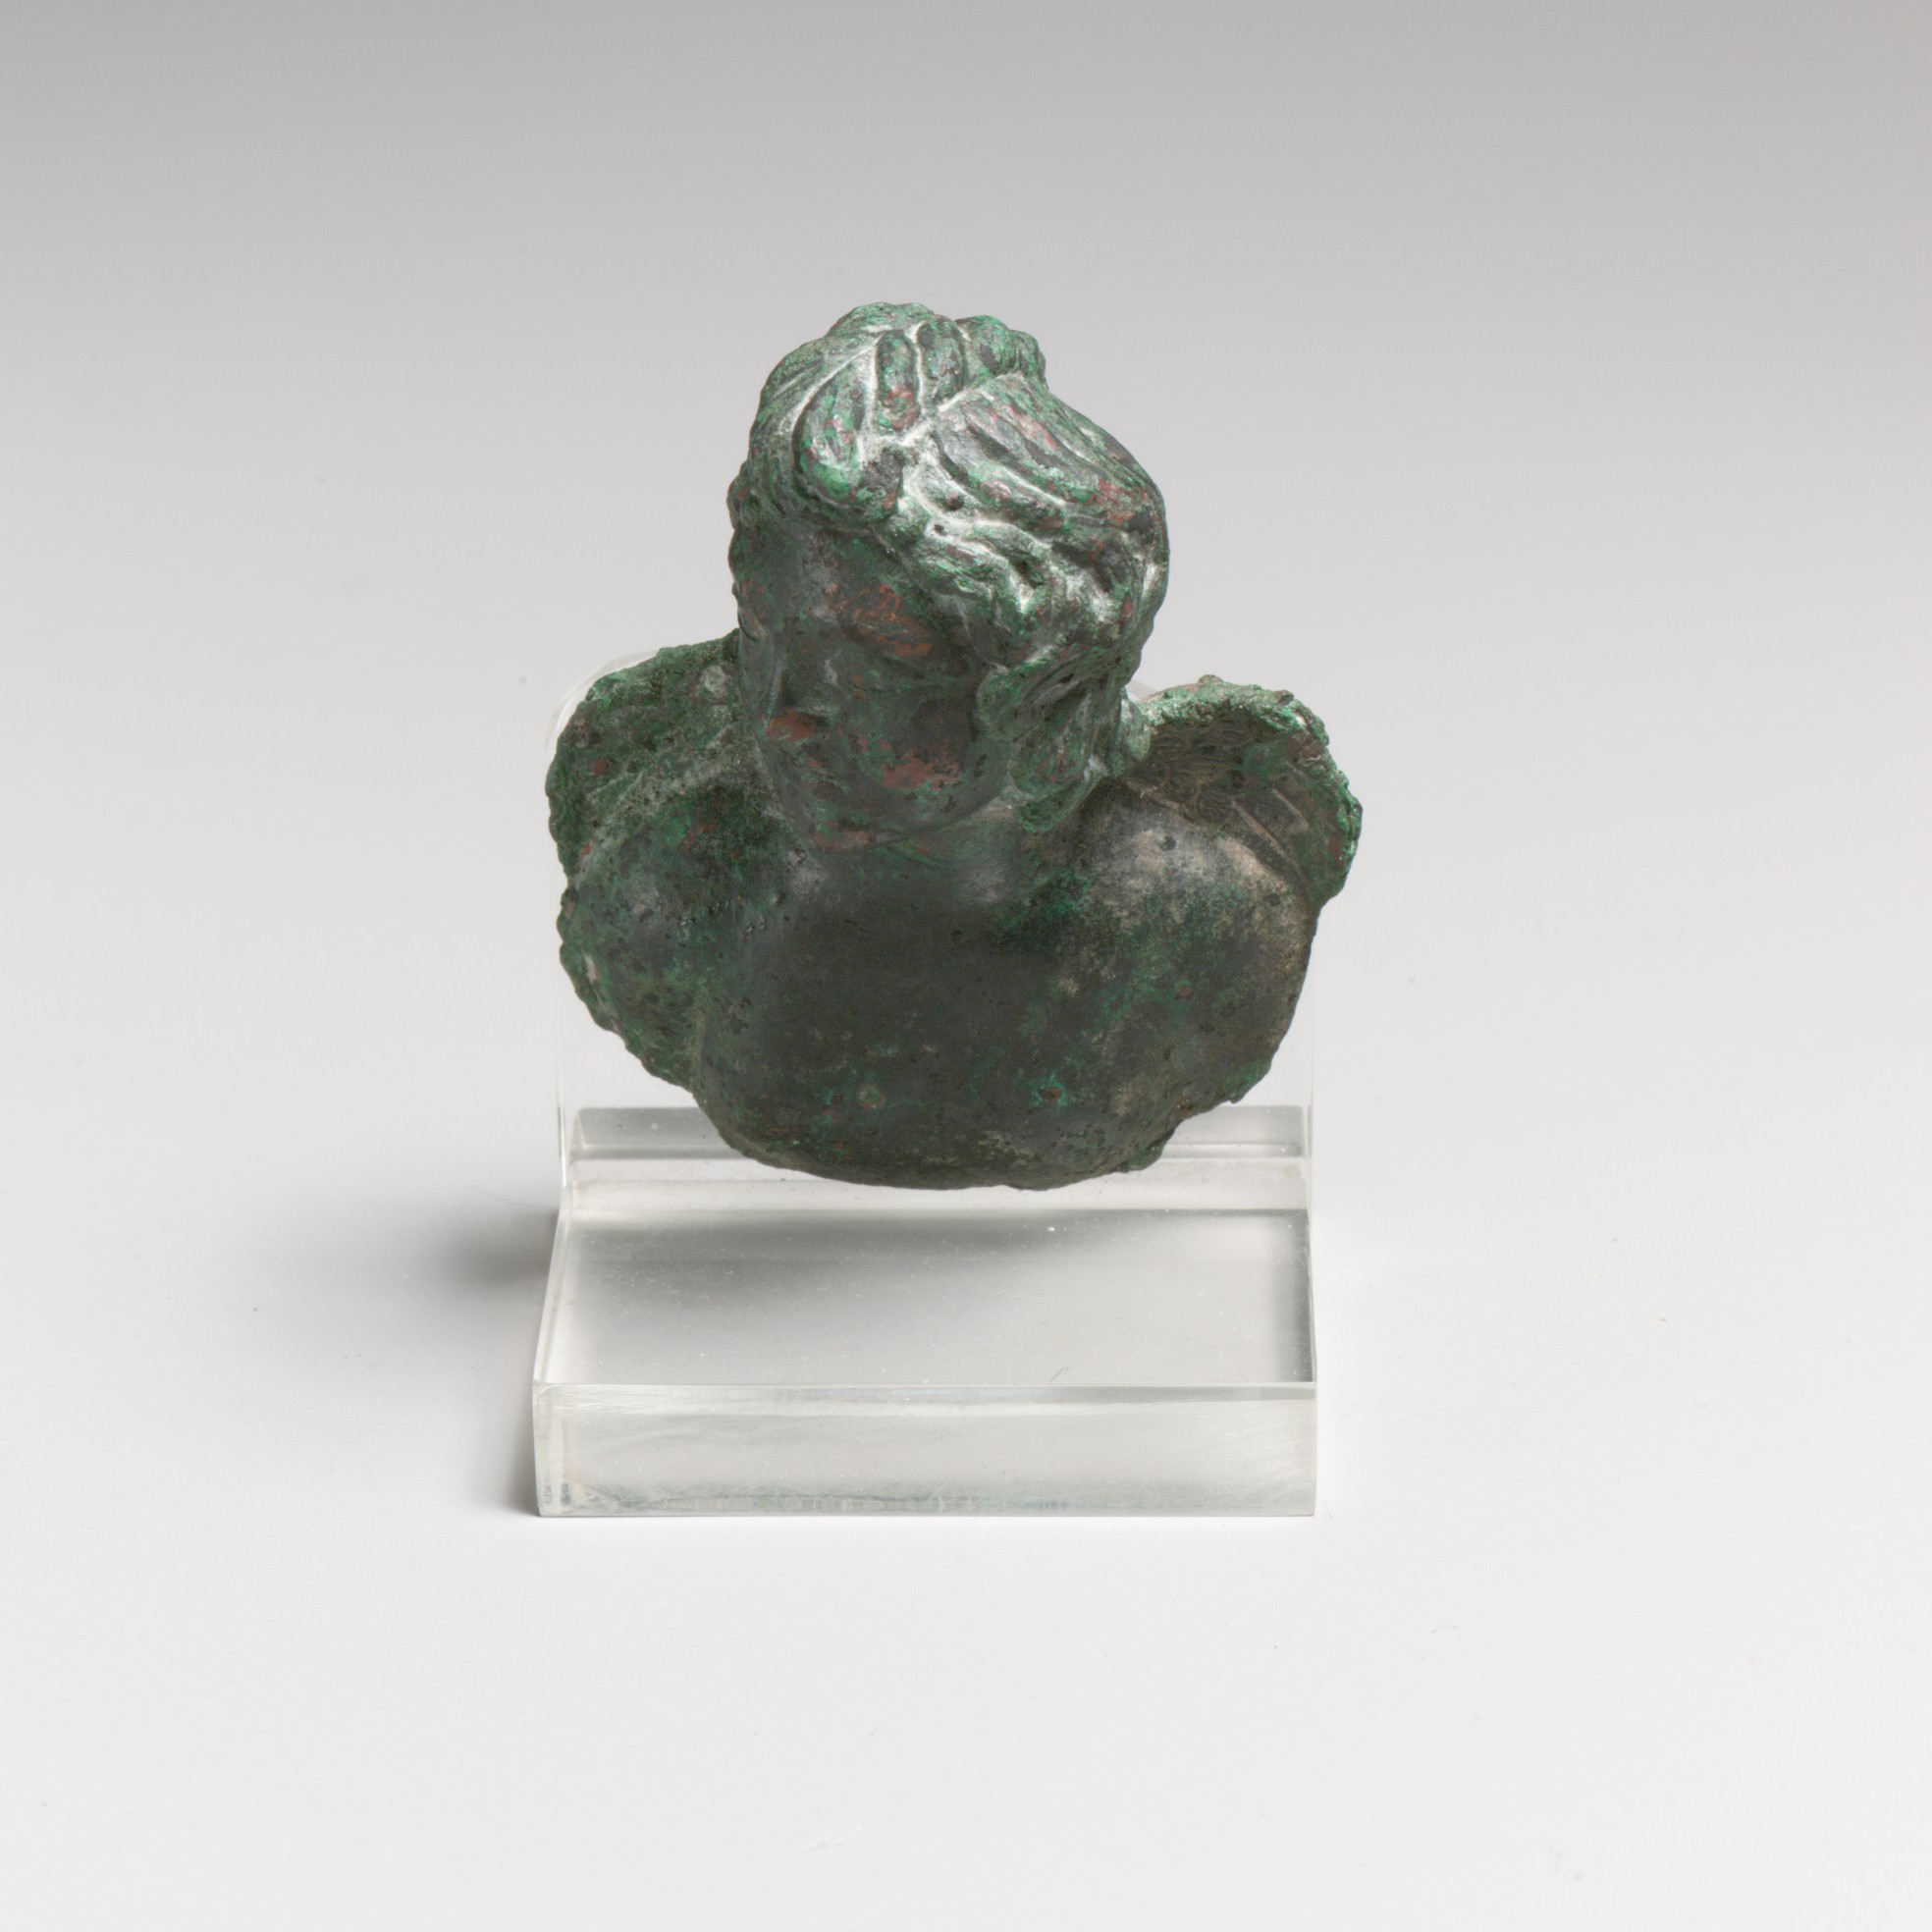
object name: furniture attachment from a couch, eros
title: Bronze fulcrum attachment with a bust of Eros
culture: roman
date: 1-100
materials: bronze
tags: eros